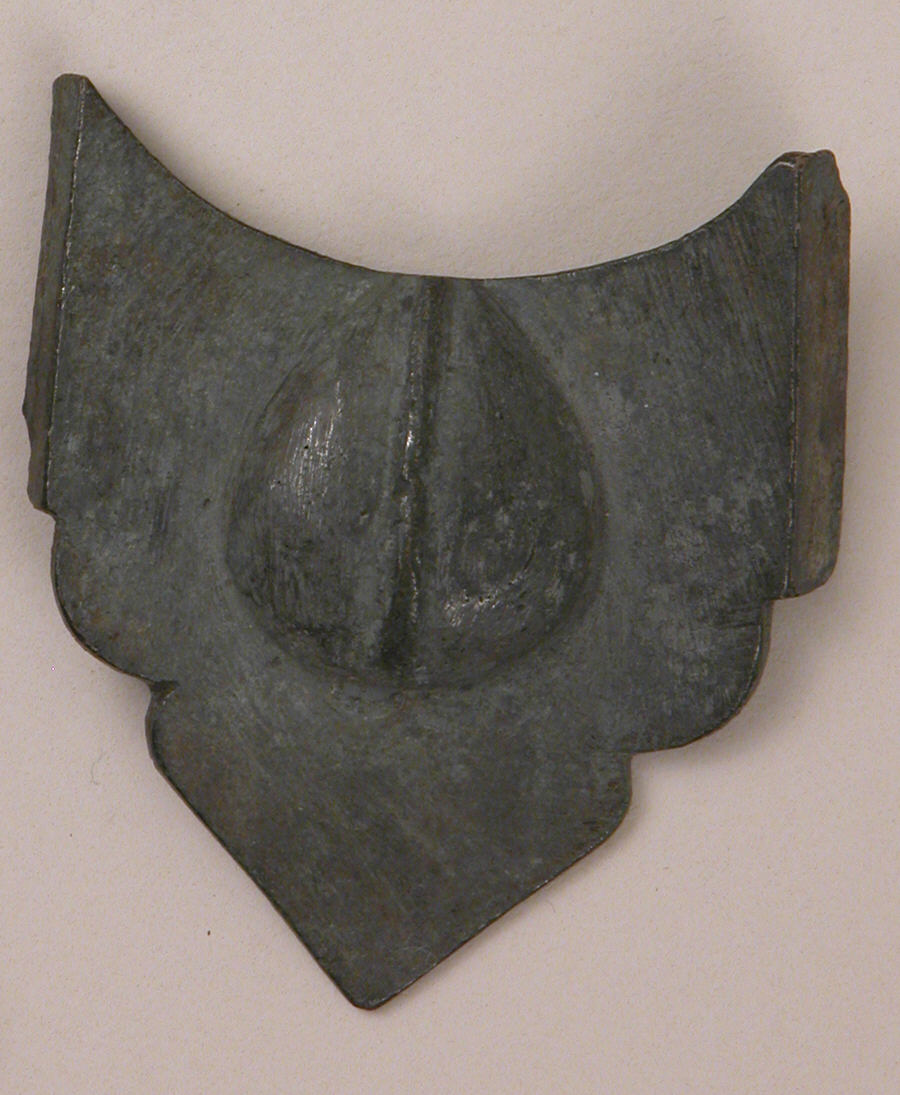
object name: belt fitting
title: Belt Fittings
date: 801-900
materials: bronze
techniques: casting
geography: iran